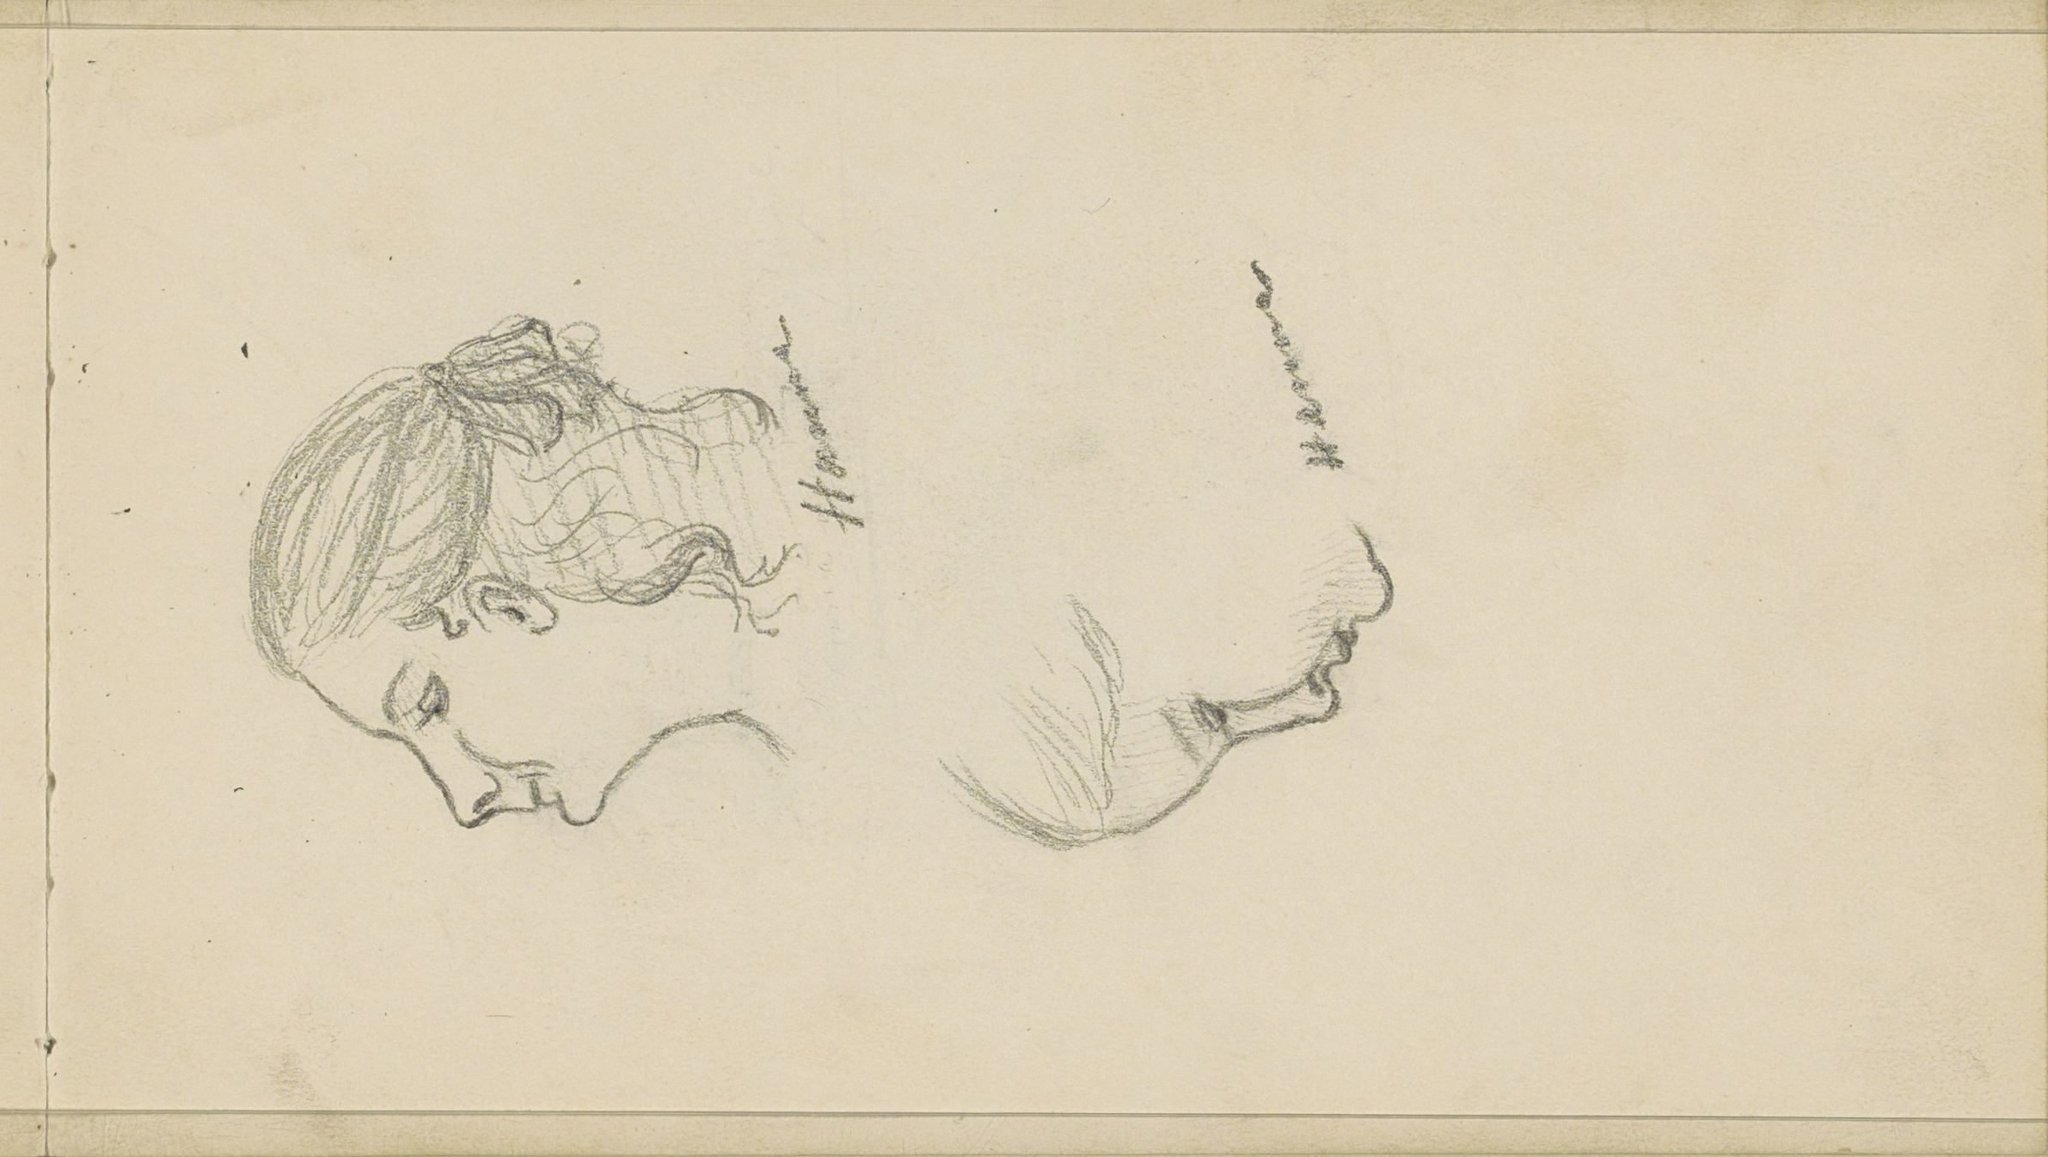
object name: sketchbook leaf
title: Portretkoppen van Hanna en Hanne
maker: julie de graag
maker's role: draughtsman, print maker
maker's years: 1877-1924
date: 1892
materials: paper, pencil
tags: head (human), adult woman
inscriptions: annotation: ‘Hanna/ Hanne’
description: Blad 6 recto uit een schetsboek met 22 bladen.